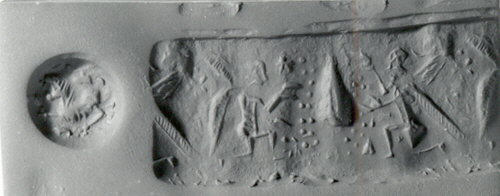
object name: stamp cylinder seal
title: Stamp-cylinder seal (with loop handle) with cultic scene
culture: urartian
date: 800-601 BCE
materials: stone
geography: urartu